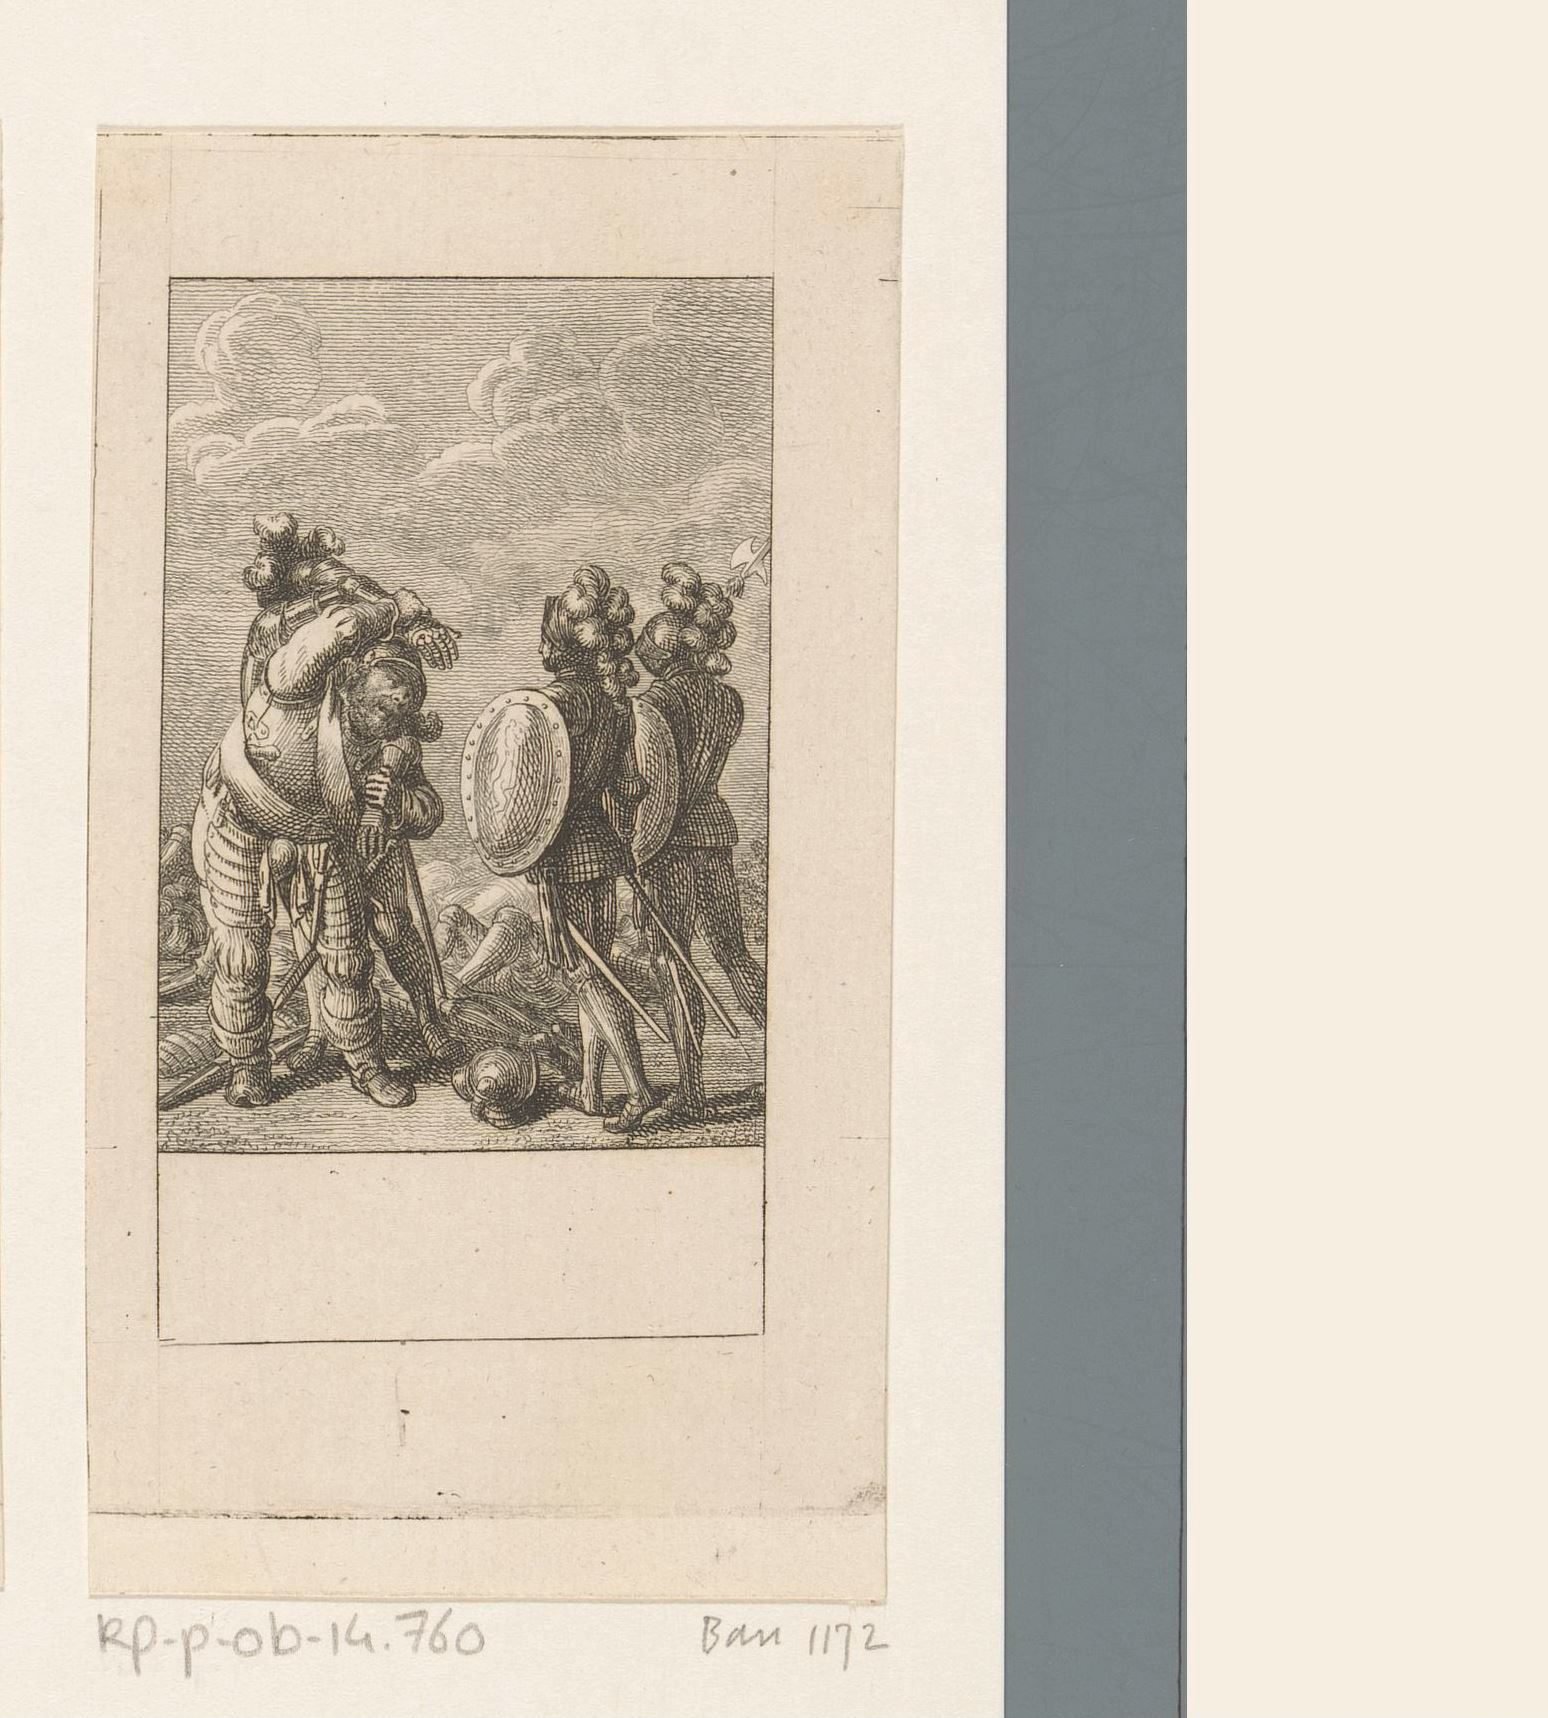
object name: print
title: Falstaff liegt over zijn overwinning op Douglas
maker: daniel nikolaus chodowiecki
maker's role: draughtsman, print maker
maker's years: 1726-1801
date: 1785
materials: paper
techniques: etching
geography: berlin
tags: william shakespeare, literature, armour, lie; 'bugia' (ripa), falstaff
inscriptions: collector's mark: Lugt 2228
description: Vervaardigd voor William Shakespeares 'Henry IV'. Latere staat gebruikt voor: Goettinger Taschen Calender vom Jahr 1786. Göttingen: Johann Christoph Dietrich, 1785.